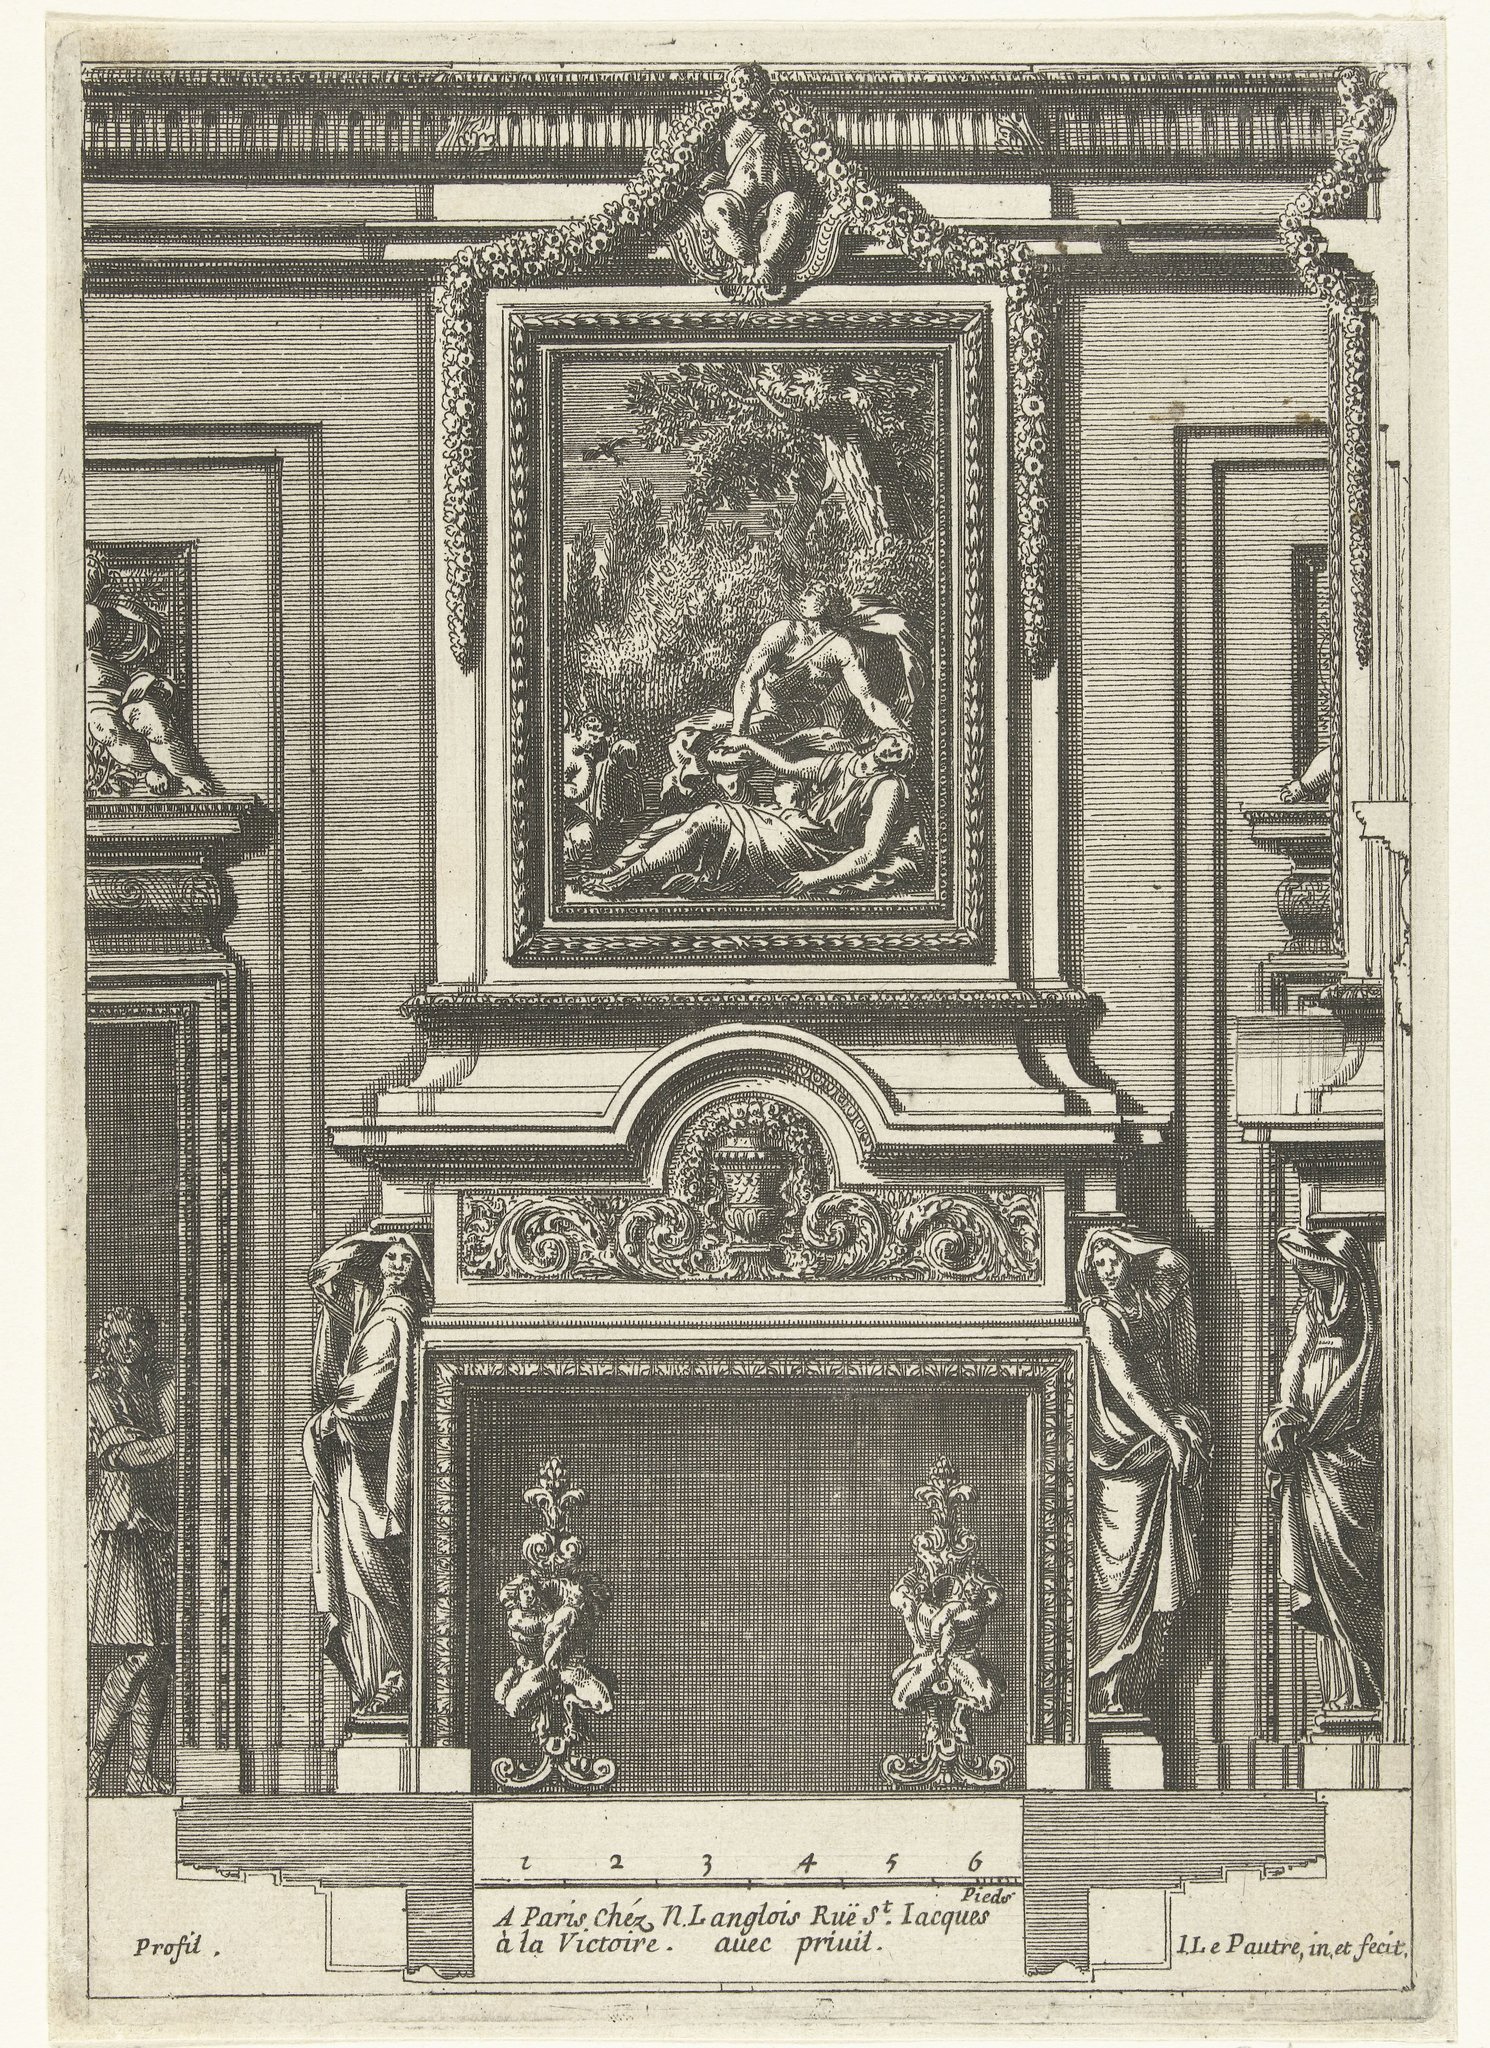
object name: print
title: Onderboezem met vierkant schilderij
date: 1665-1670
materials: paper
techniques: etching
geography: france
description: Op het schilderij staat de dood van Procris (?). Blad 4 uit serie van 6.